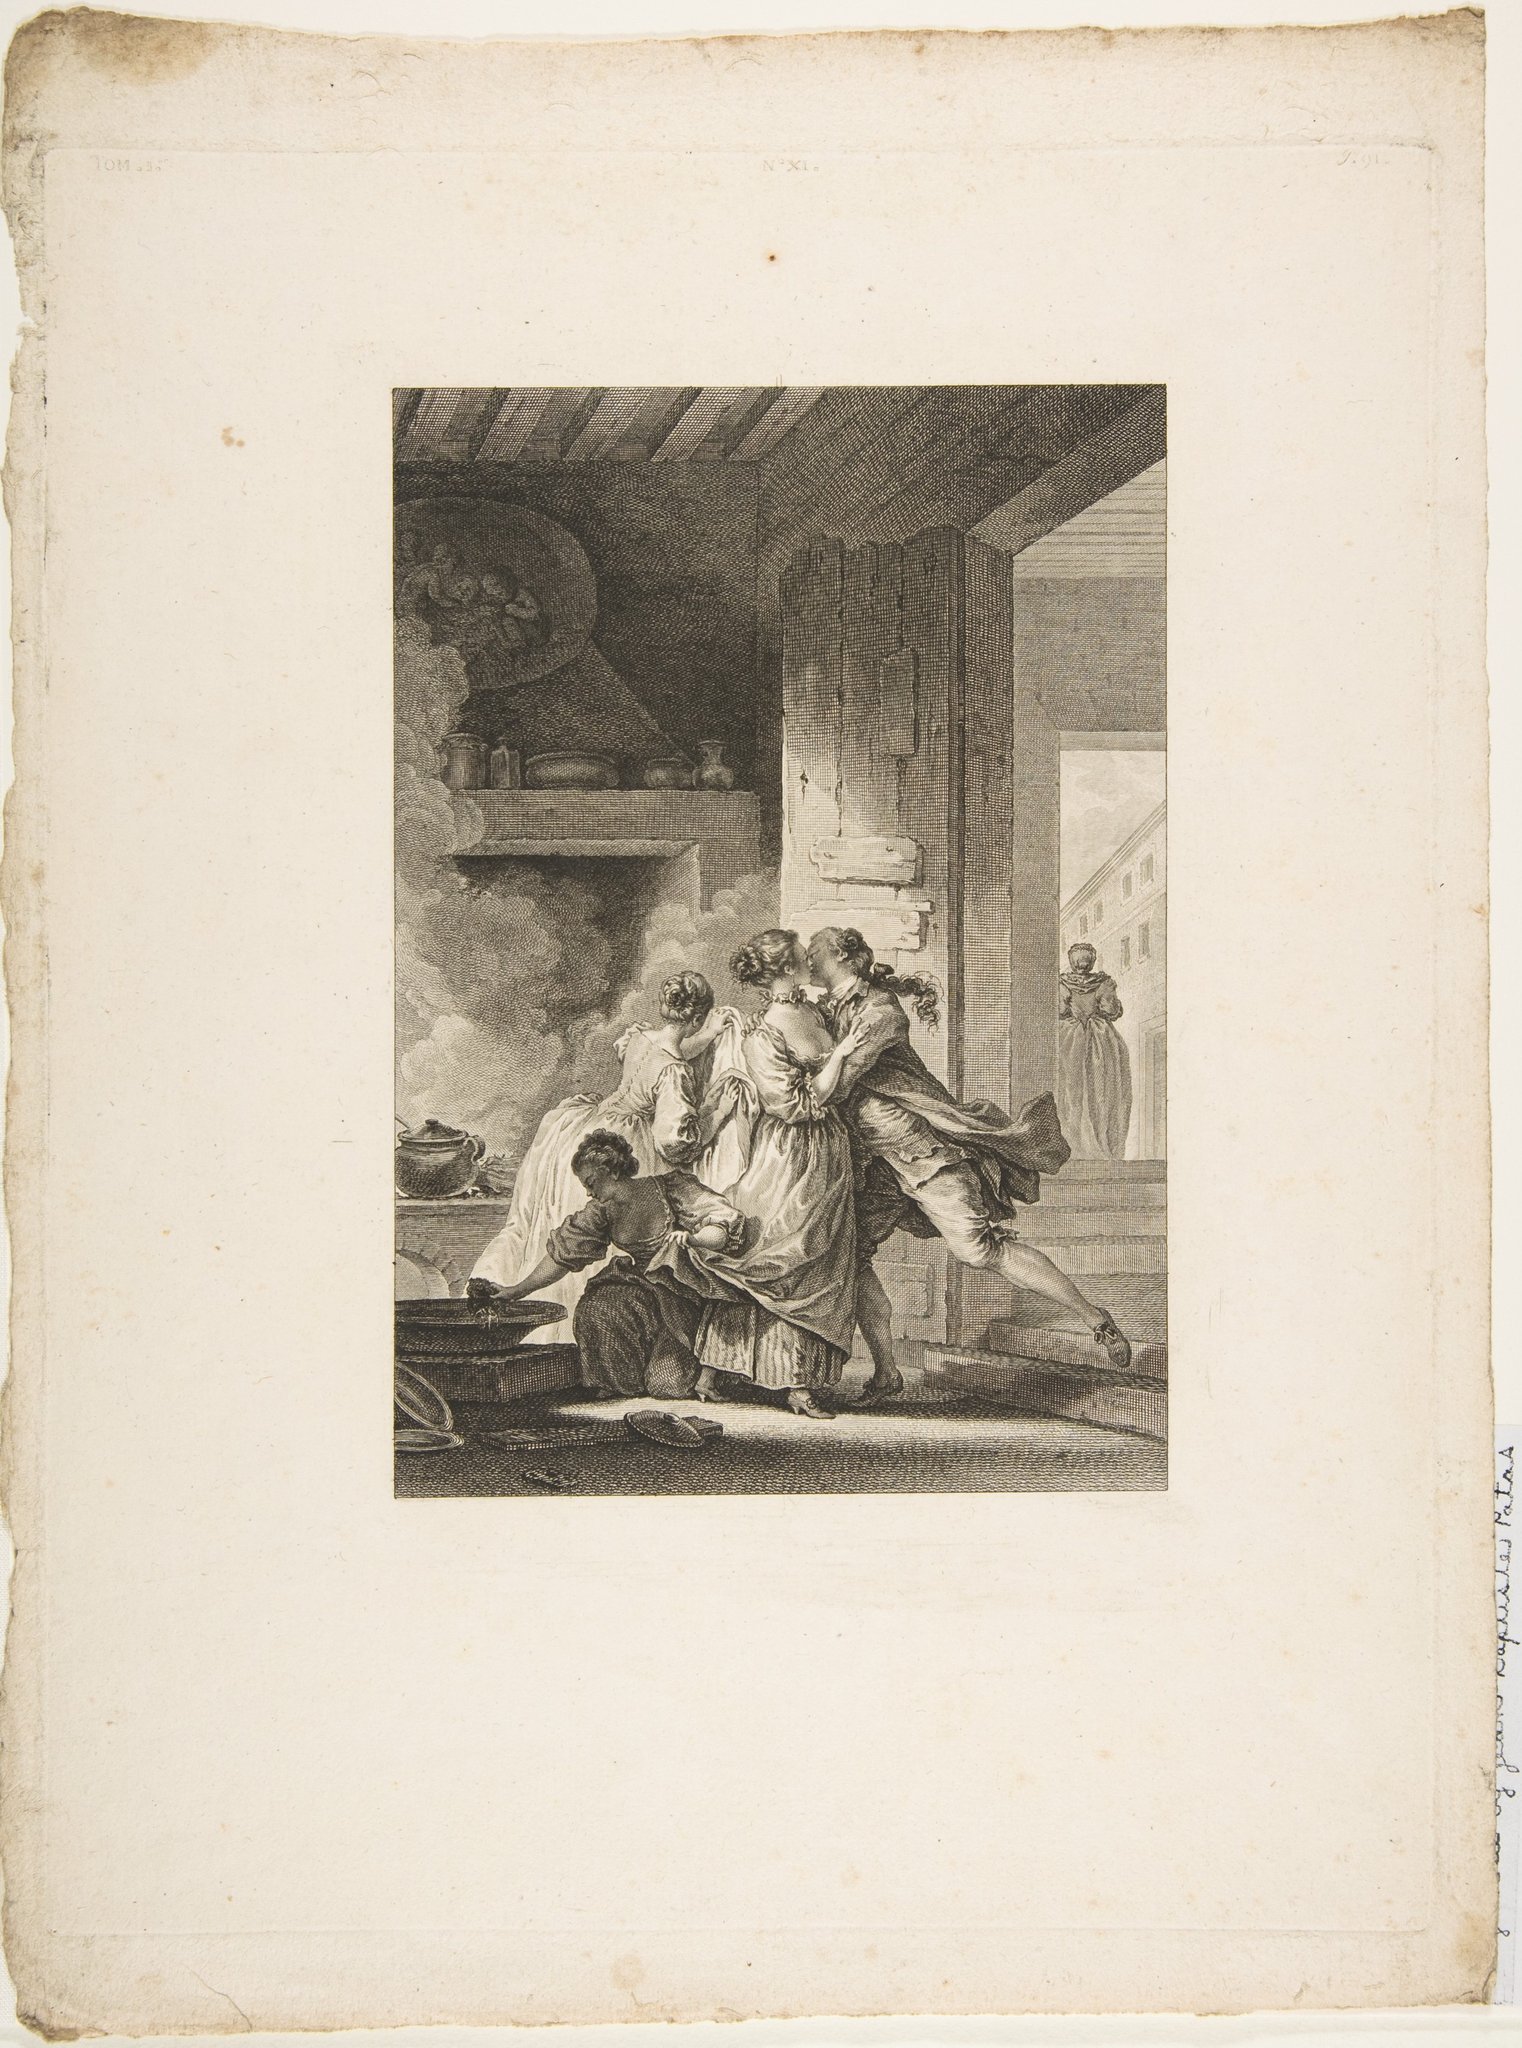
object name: print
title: On ne s'avise jamais du tout, from "Contes et nouvelles en vers par Jean de La Fontaine. A Paris, de l'imprimerie de P. Didot, l'an III de la République, 1795"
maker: jean-baptiste patas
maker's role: artist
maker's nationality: french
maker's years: 1744-1802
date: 1795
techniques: engraving, etching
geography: paris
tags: interiors,couples,women